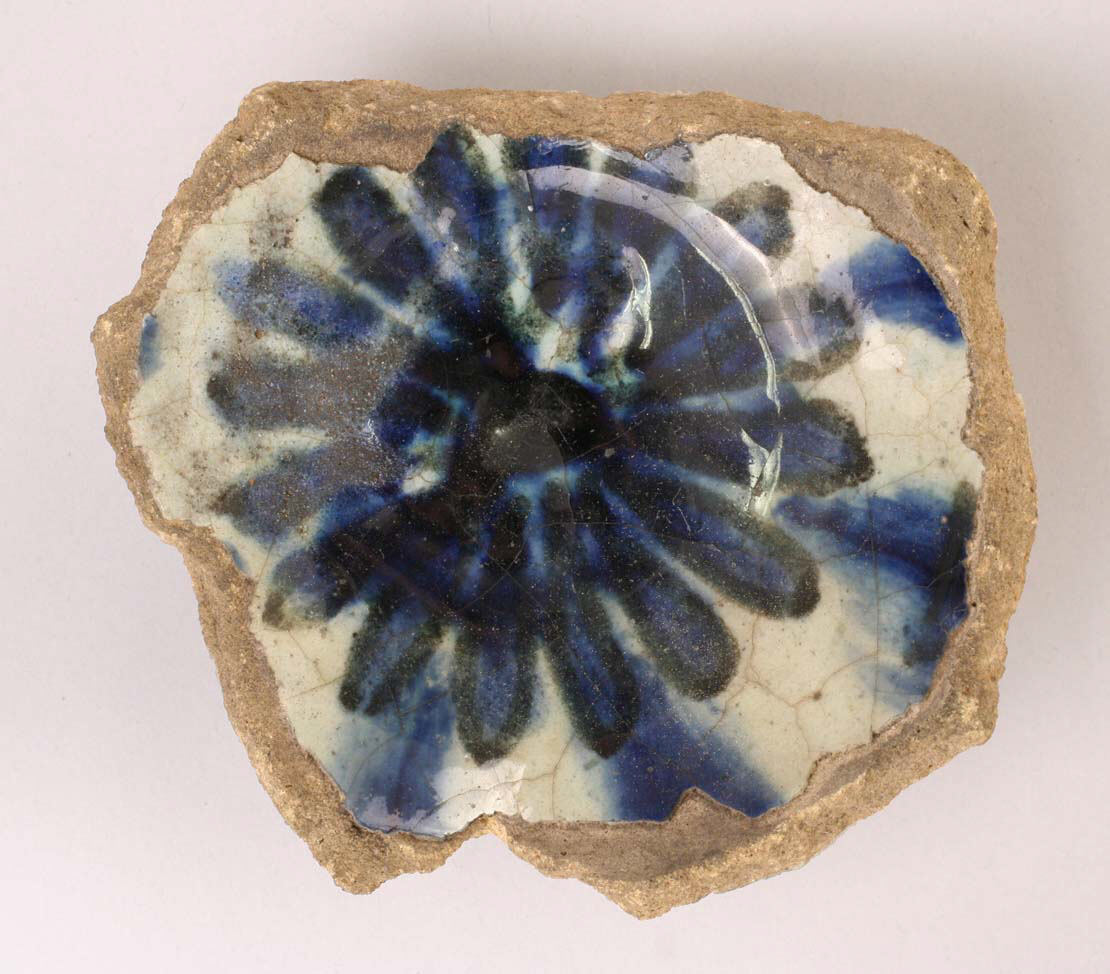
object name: ceramic fragment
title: Fragment of a Bowl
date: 1301-1500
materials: glaze, stonepaste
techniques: painting, polychrome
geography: egypt or syria